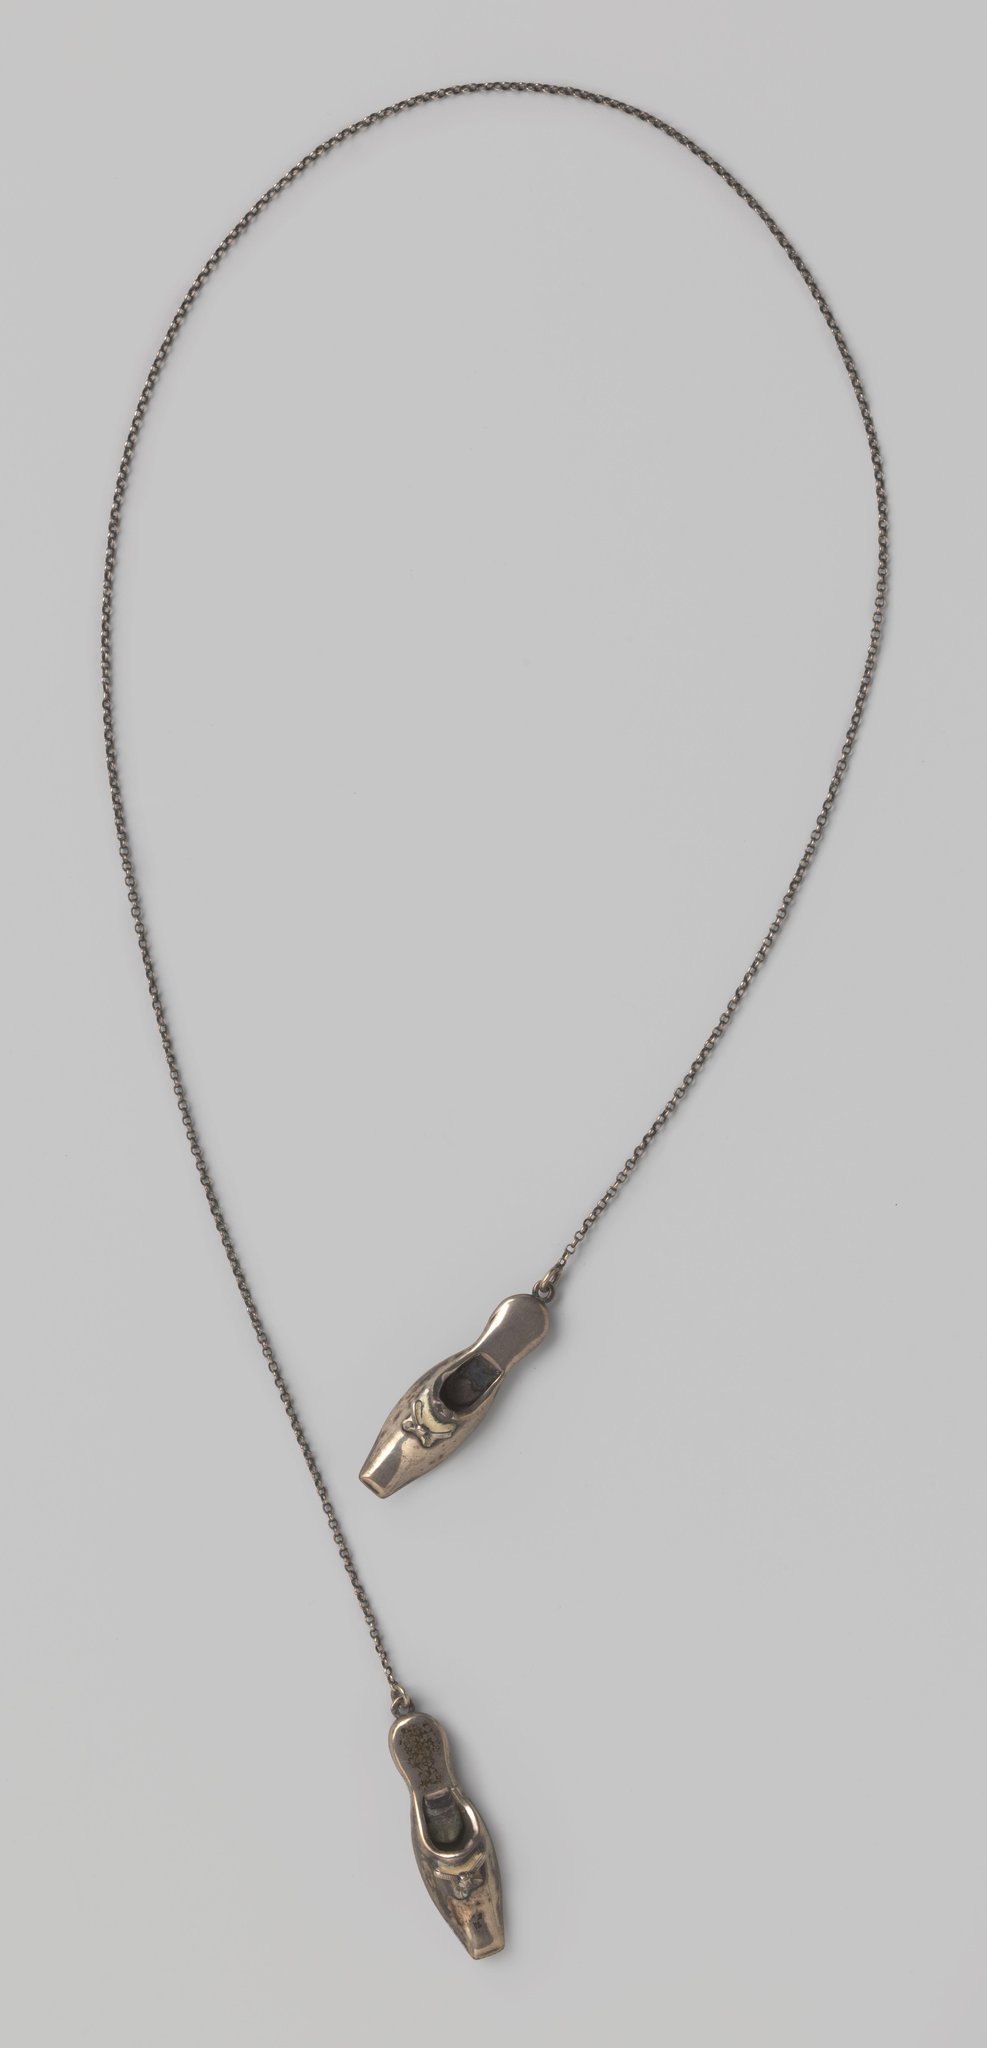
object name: breinaalddop, breidop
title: Paar zilveren breidoppen in de vorm van muiltjes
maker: Anonymous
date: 1400-1950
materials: silver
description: Paar zilveren breidoppen in de vorm van muiltjes, verbonden door een ketting.